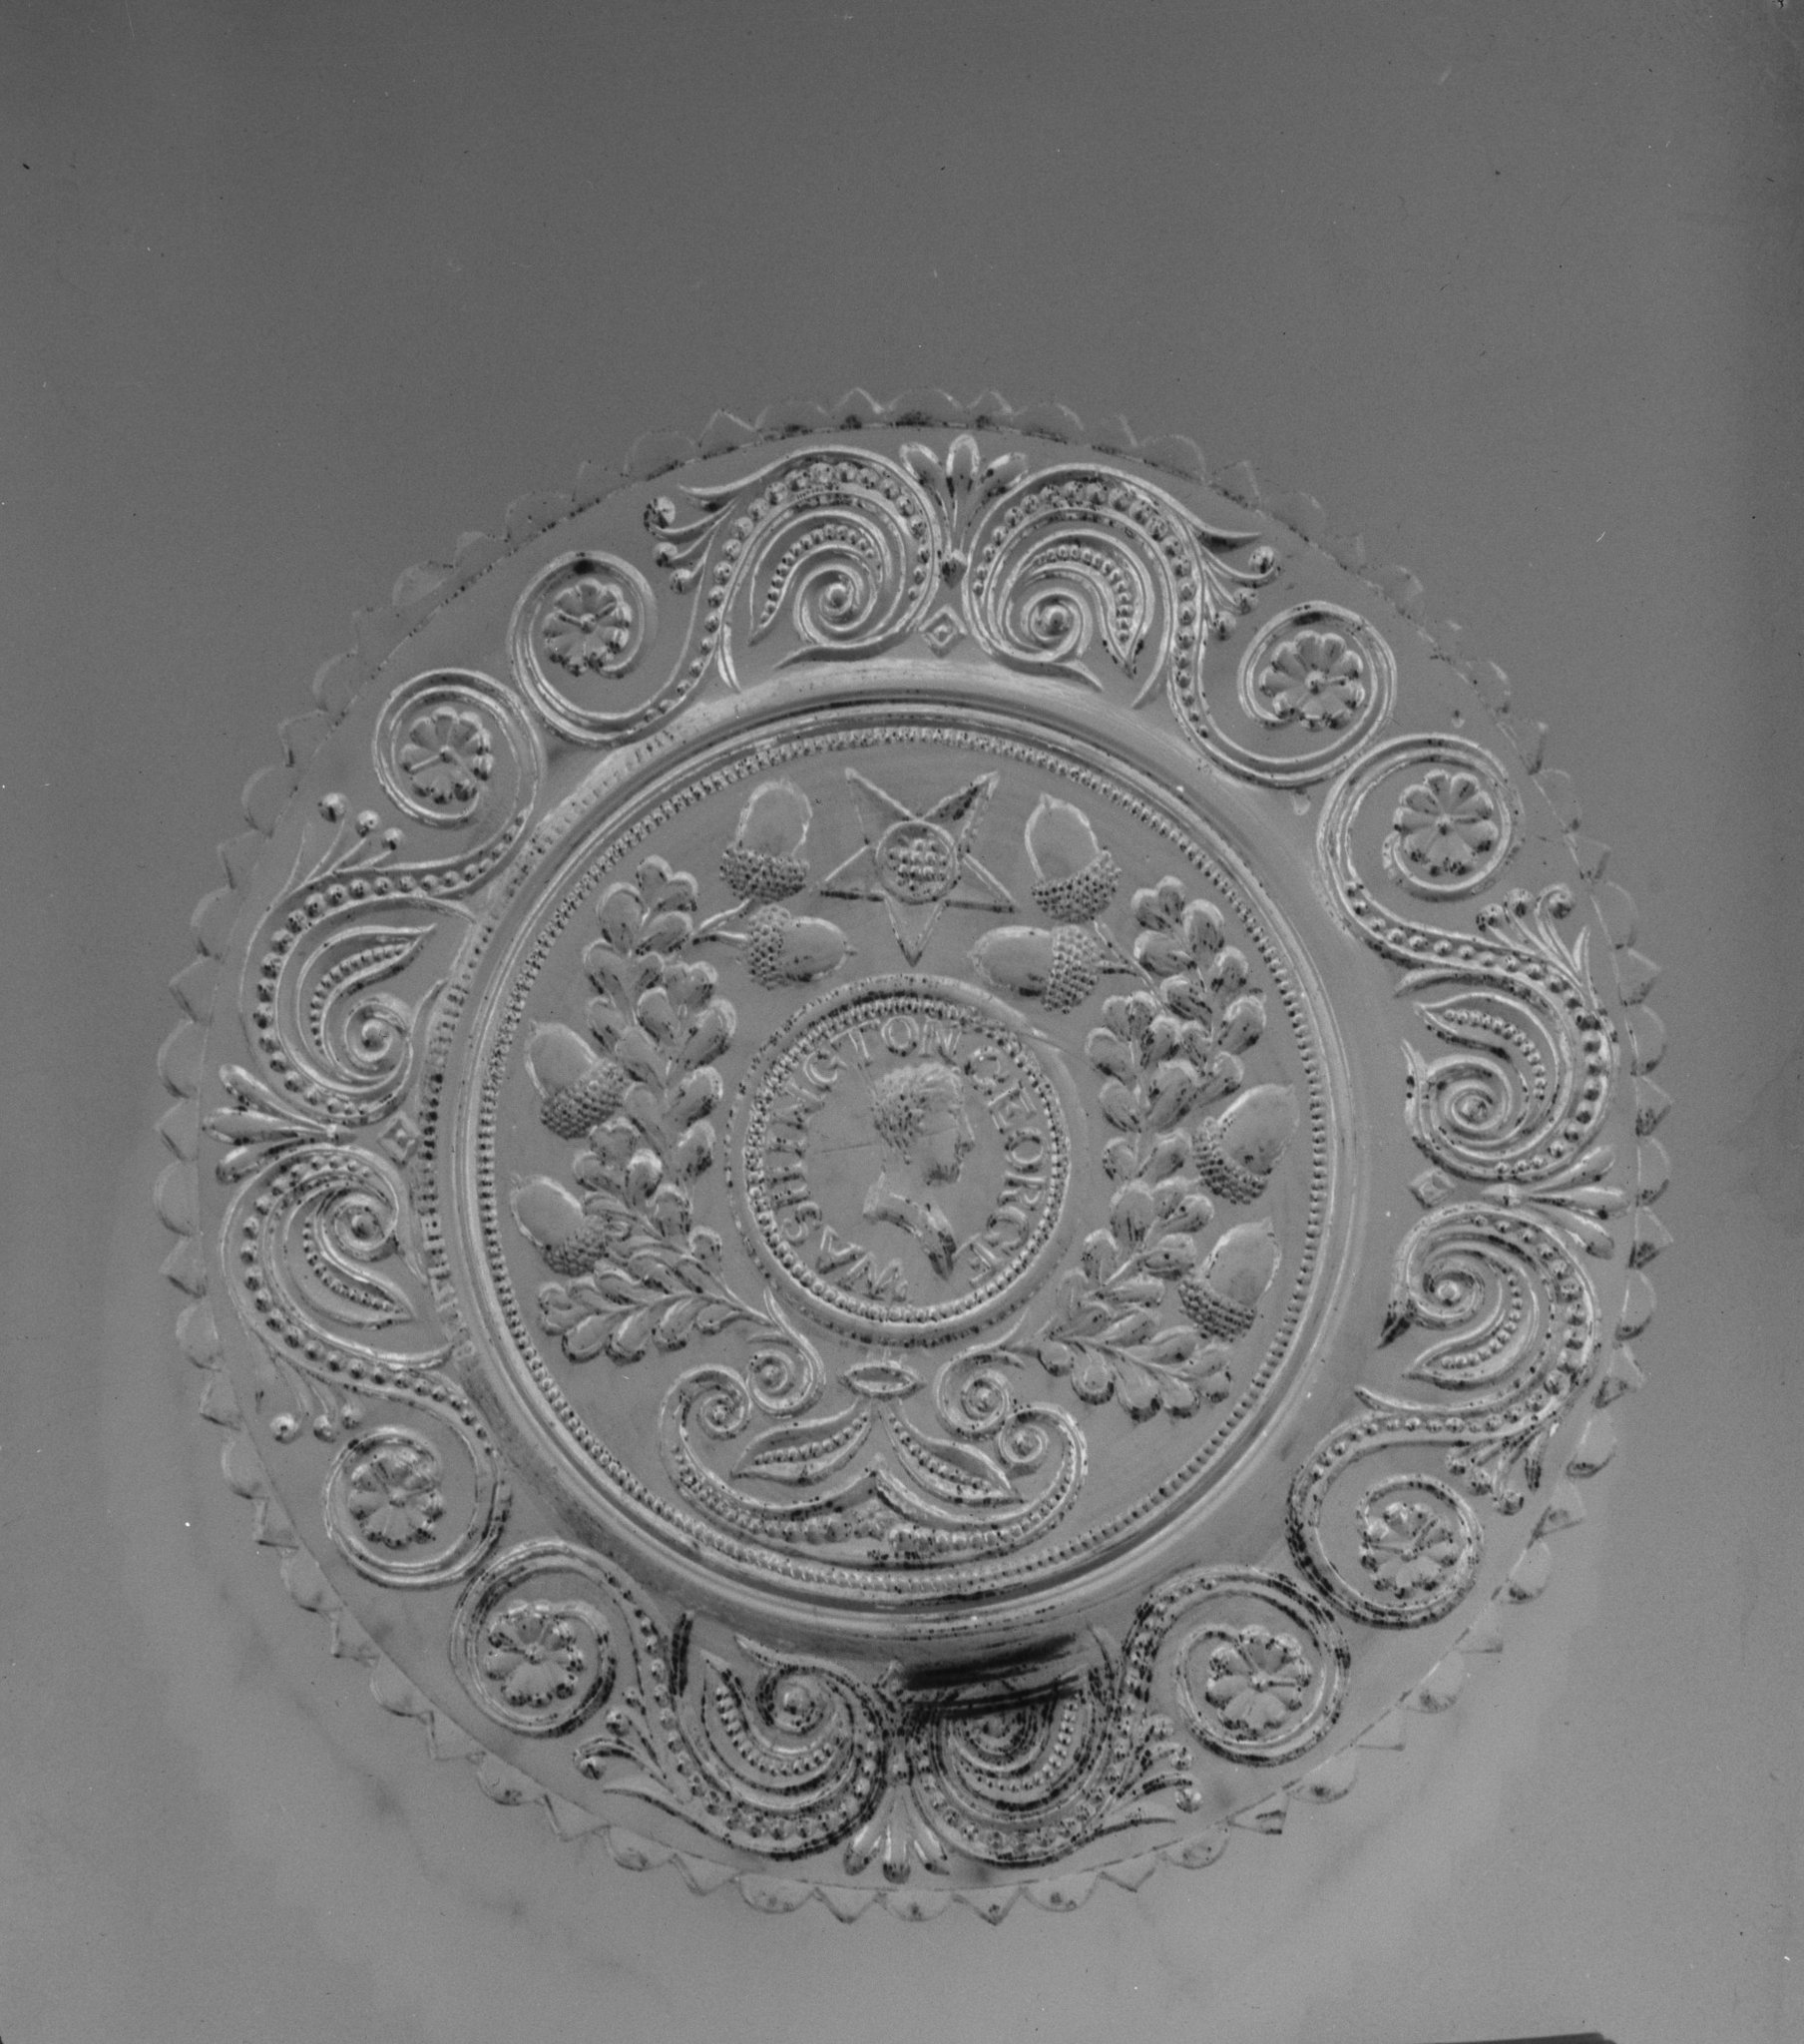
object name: plate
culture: american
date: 1832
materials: glass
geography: united states